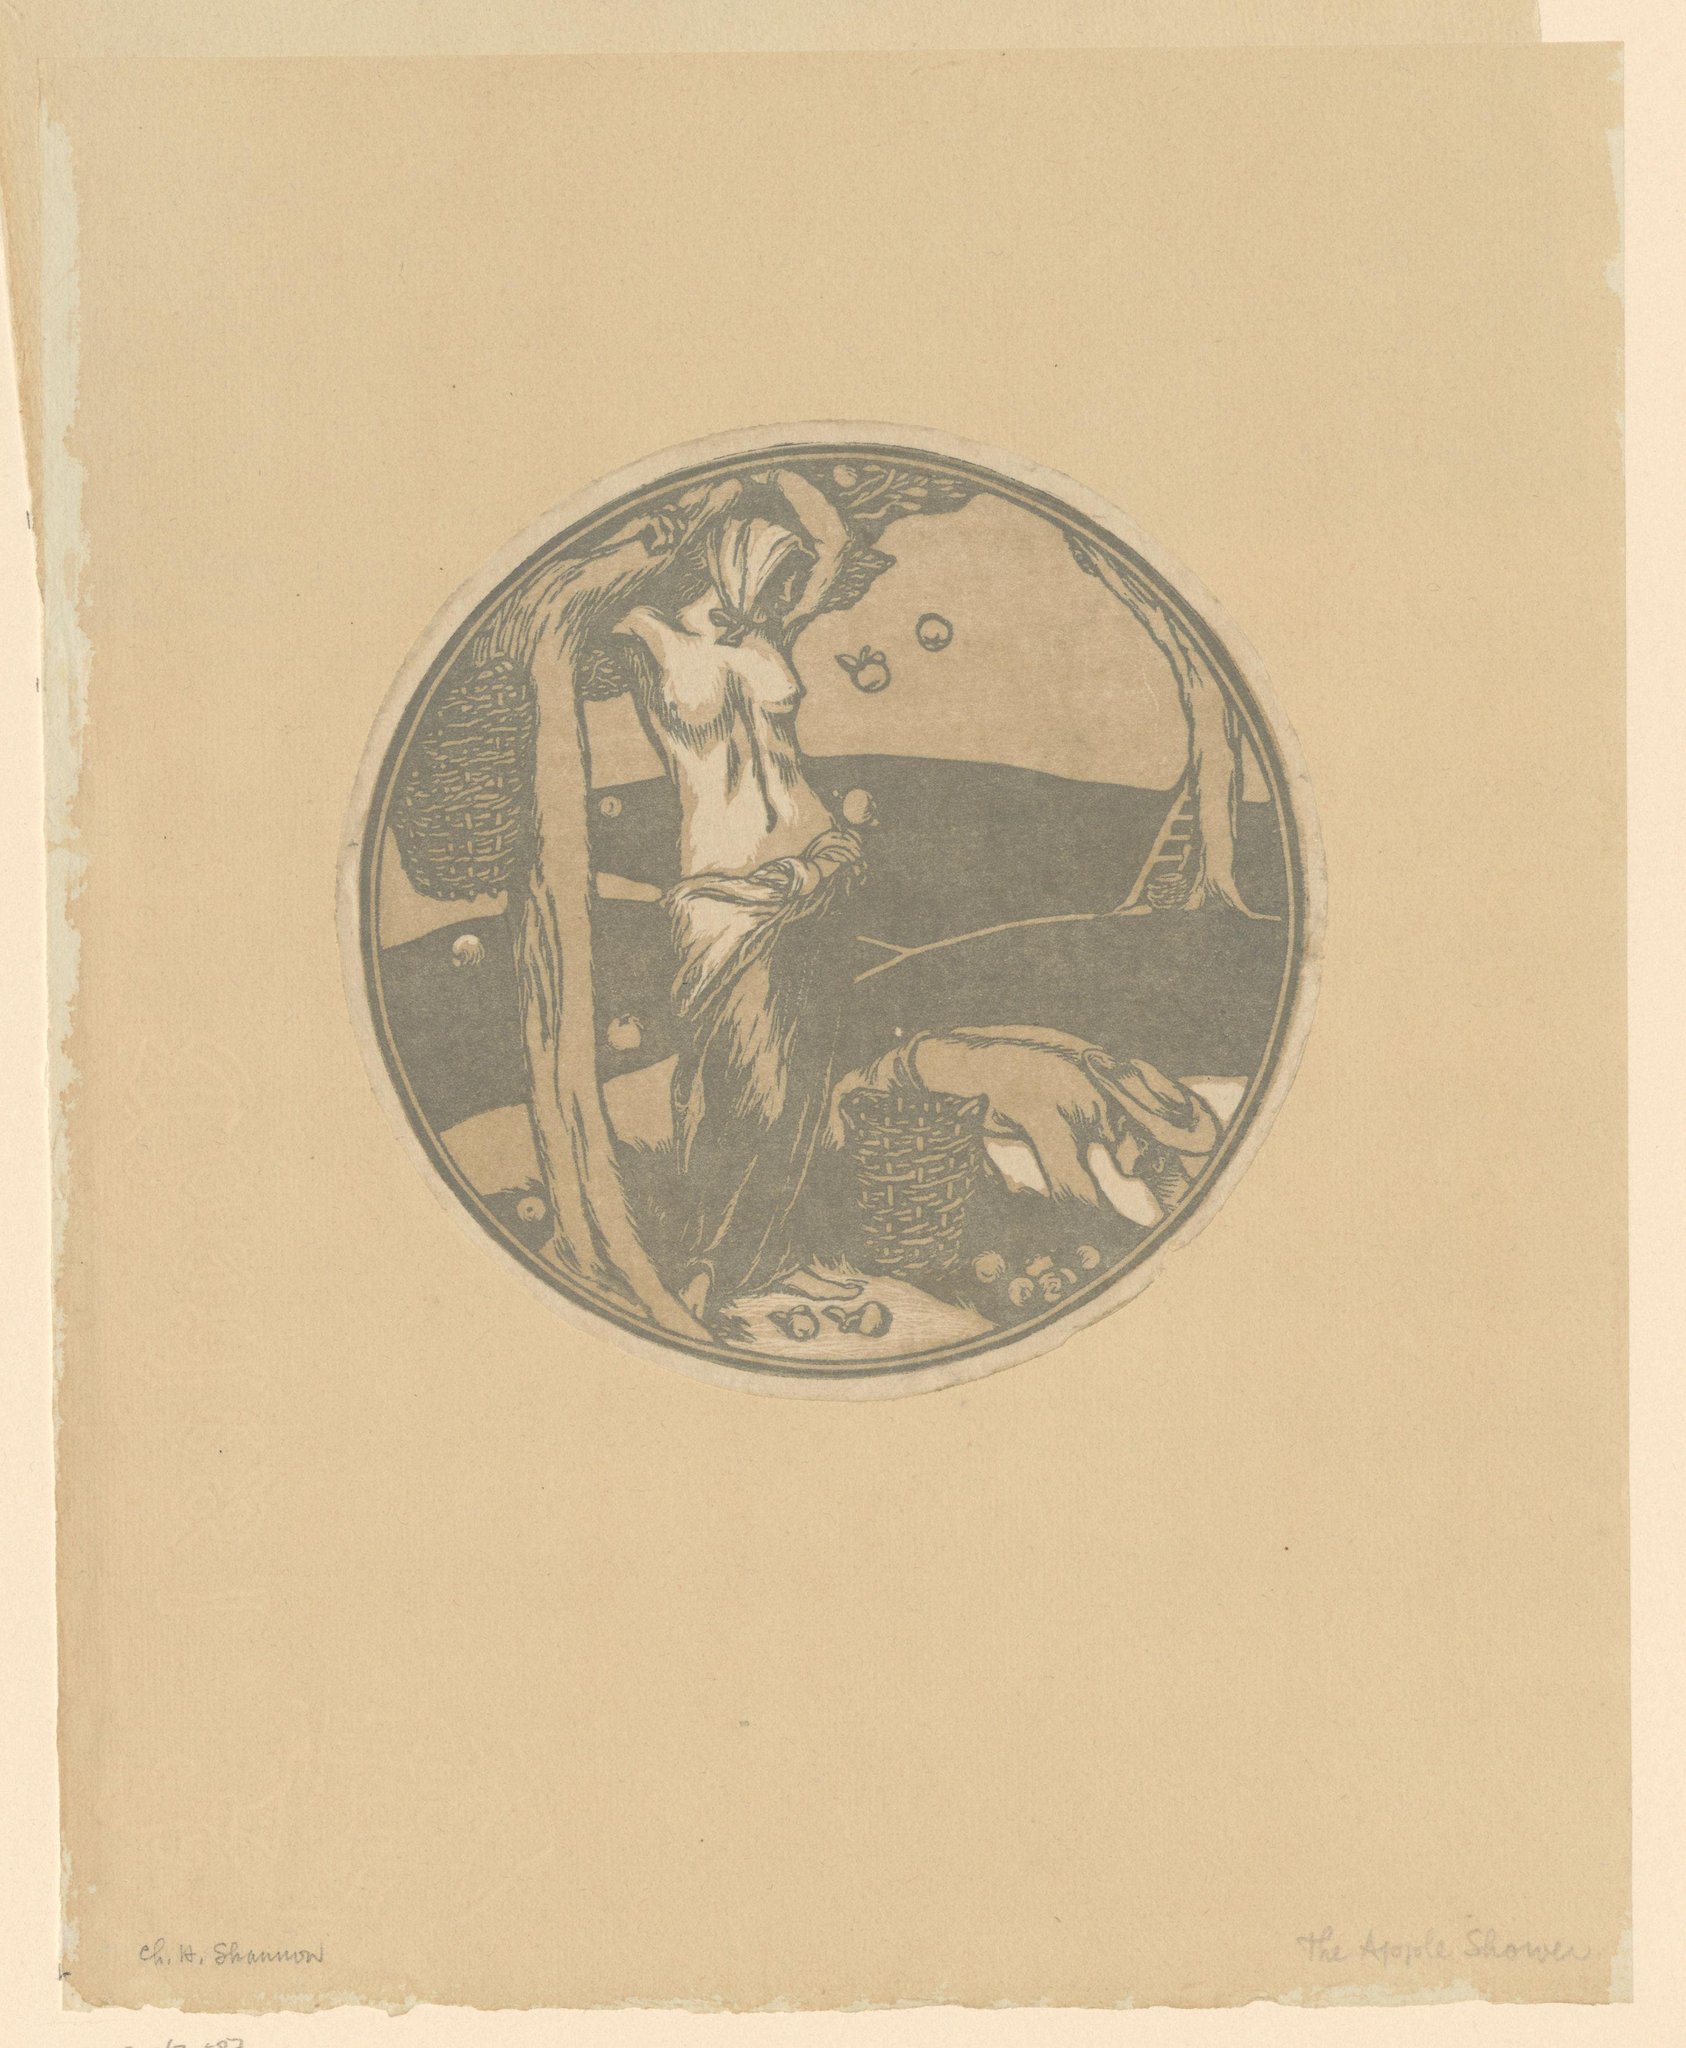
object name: print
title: Oogsten van appels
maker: charles haslewood shannon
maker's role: draughtsman, print maker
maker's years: 1865-1937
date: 1898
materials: paper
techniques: woodcut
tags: trees: apple-tree, fruit harvest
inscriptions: inscription: ‘[al]bois 3713’, watermark: ‘Charles I’, collector's mark: Lugt 2228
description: Prent maakt waarschijnlijk deel uit van een serie met twaalf voorstellingen. Over deze serie is verder niets bekend. Het betreft voornamelijk voorstellingen met betrekking tot de twaalf maanden van het jaar en oogsten.